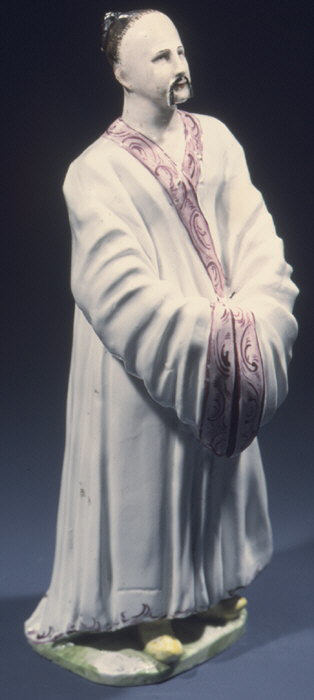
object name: figure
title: Tatar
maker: imperial porcelain manufactory, st. petersburg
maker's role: manufactory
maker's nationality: russian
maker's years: 1744-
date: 1760-1770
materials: hard paste porcelain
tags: men